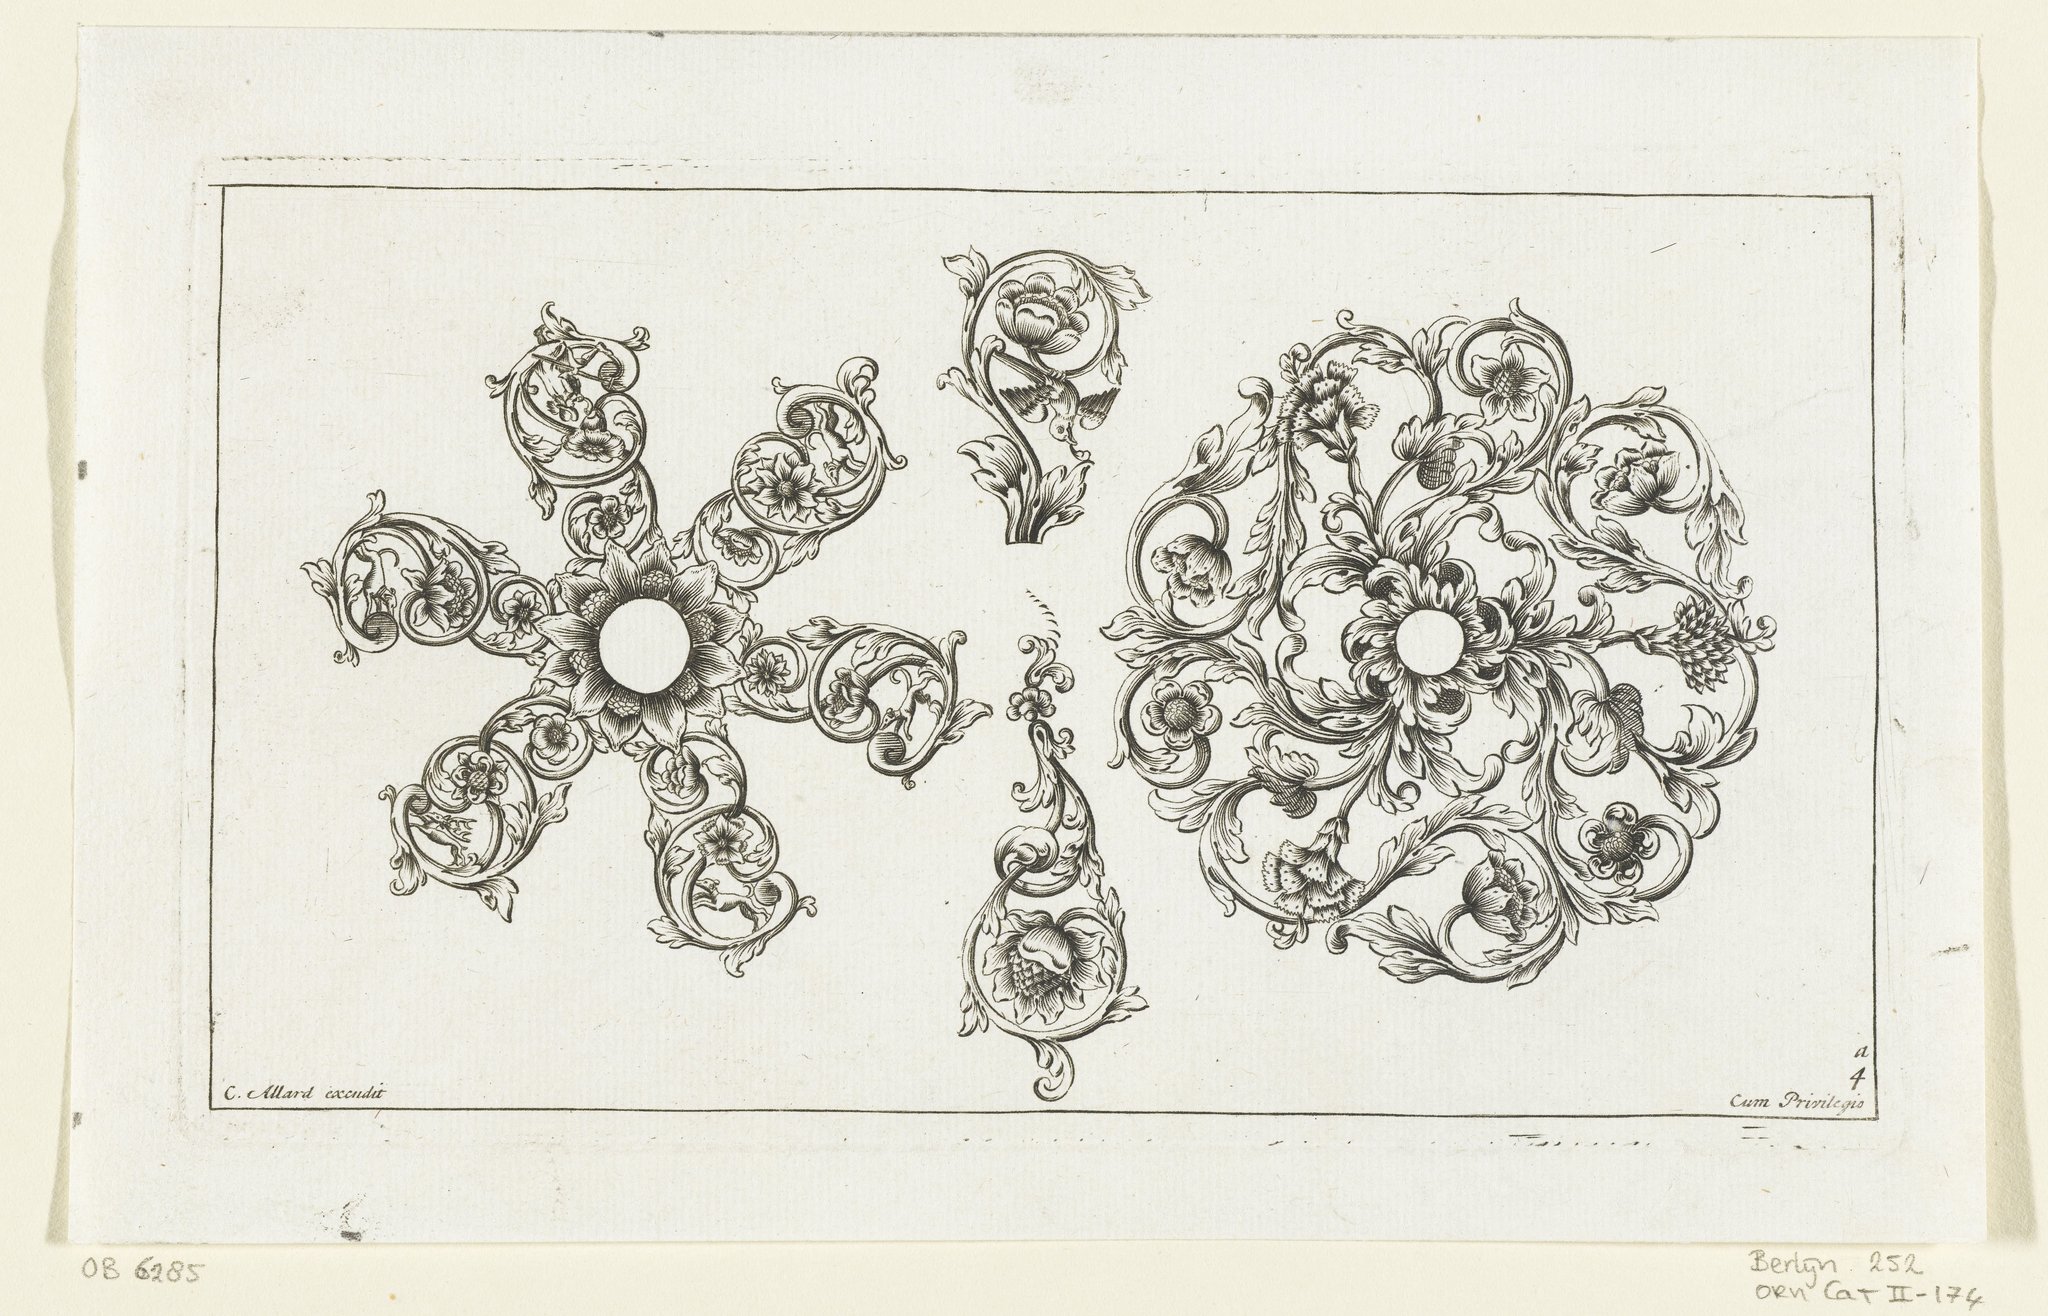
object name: ornament print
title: Alderhande Voorbeelden van Doorgebroken Zilver-Smids Werk (...)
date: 1690-1700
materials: paper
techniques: engraving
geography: amsterdam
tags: ornament derived from plant forms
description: Een jager met honden en een hert is verwerkt in het stervormige motief links. Uit serie van 6 bladen met voorbeelden van ornamenten voor zilversmeden.